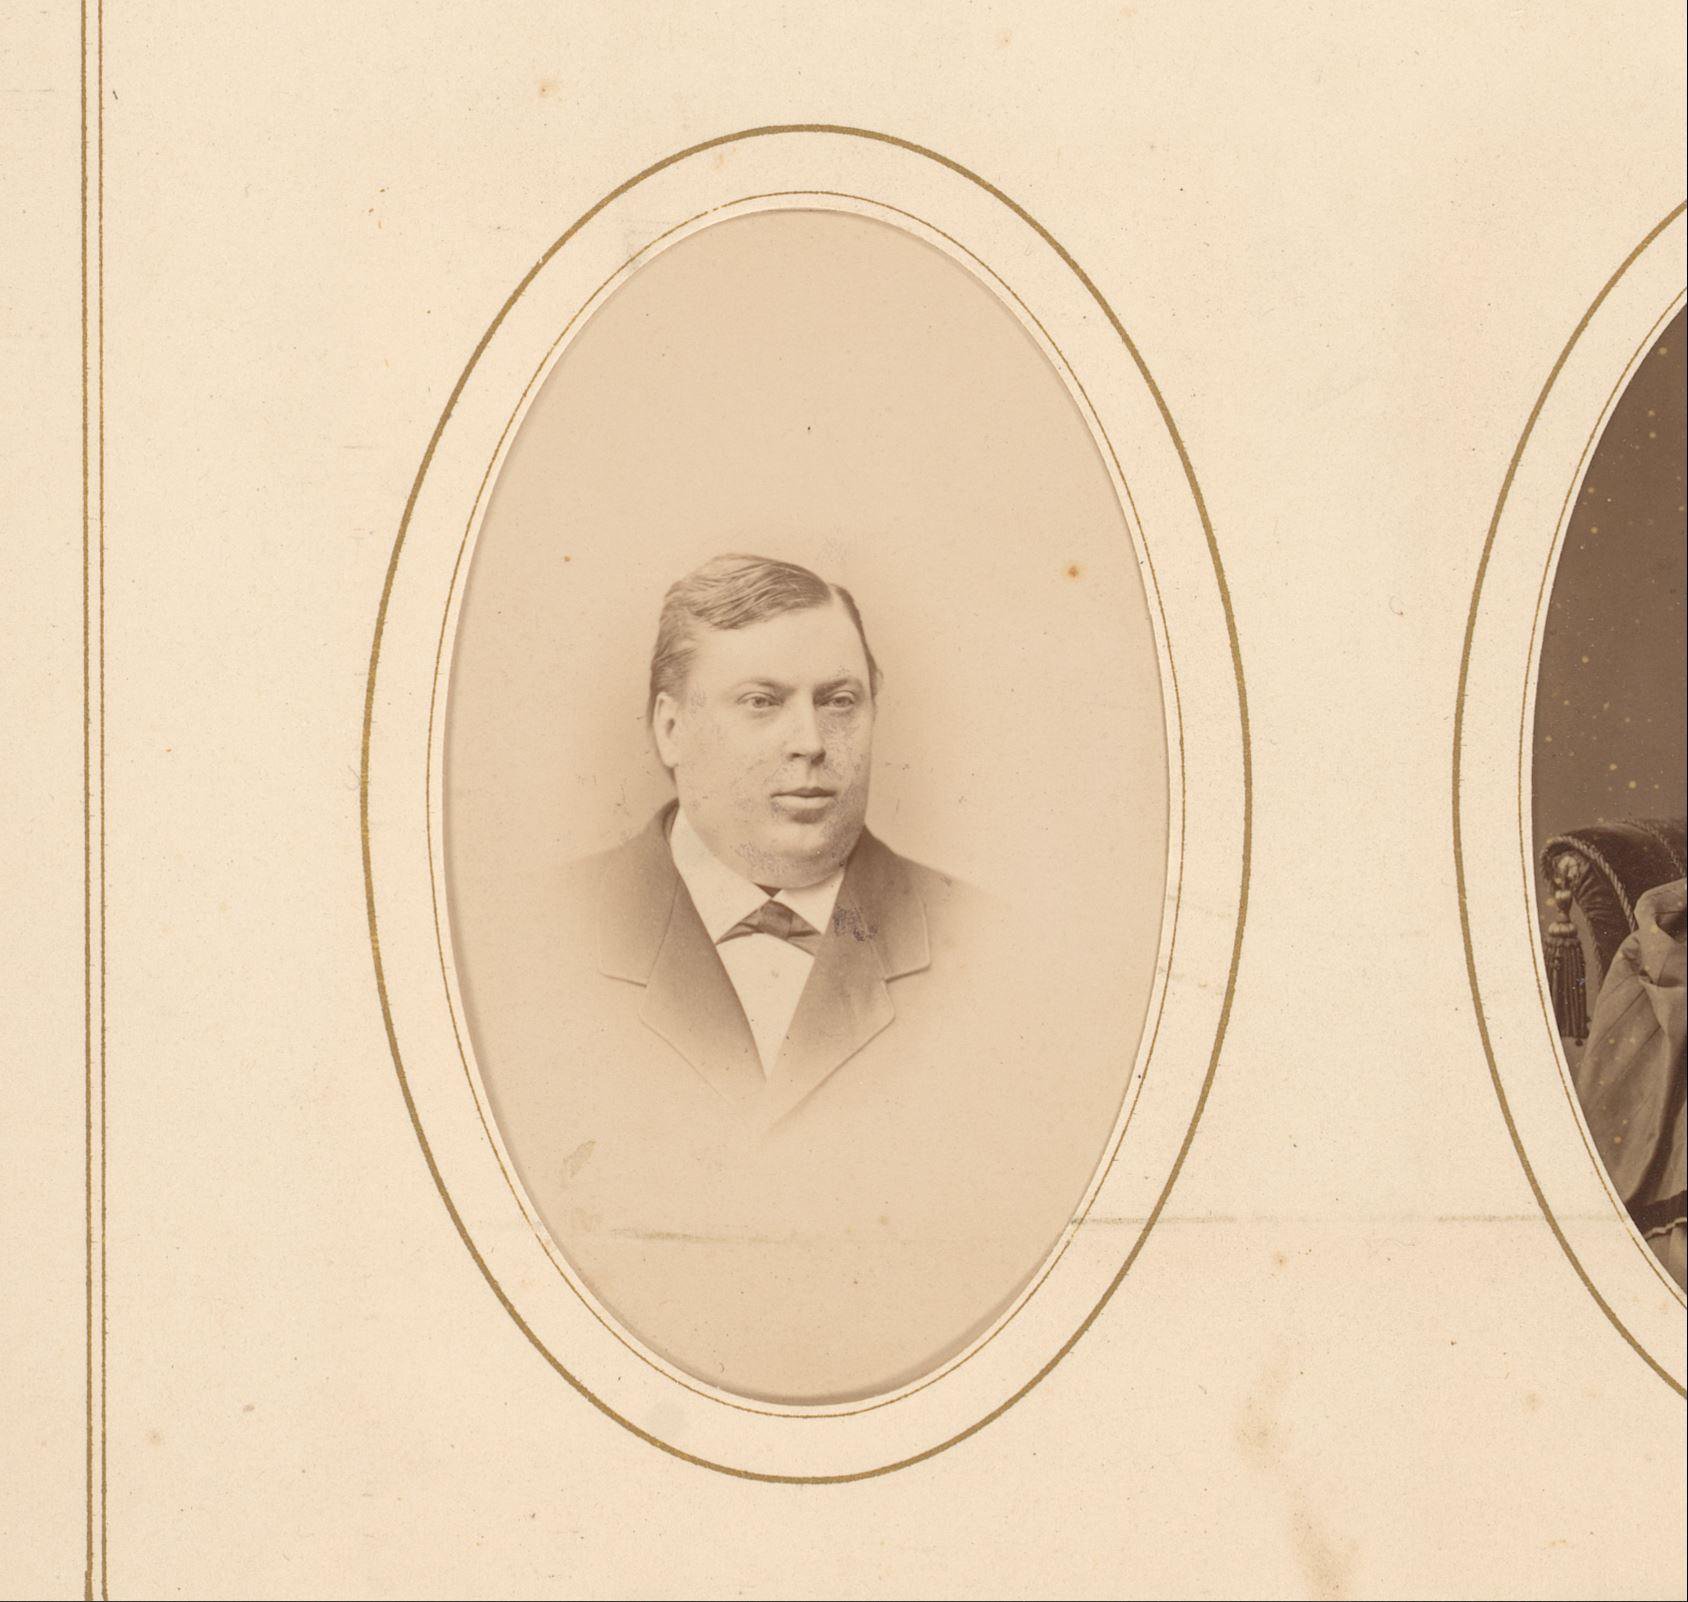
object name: photograph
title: Portret van een man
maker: emil tiedemann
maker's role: fotograaf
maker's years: 1858-1892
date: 1859-1892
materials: cardboard, photographic support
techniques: albumen print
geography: germany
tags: historical persons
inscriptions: inscription: ‘EMIL TIEDEMANN/ HOF-PHOTOGRAPH/ (...)’